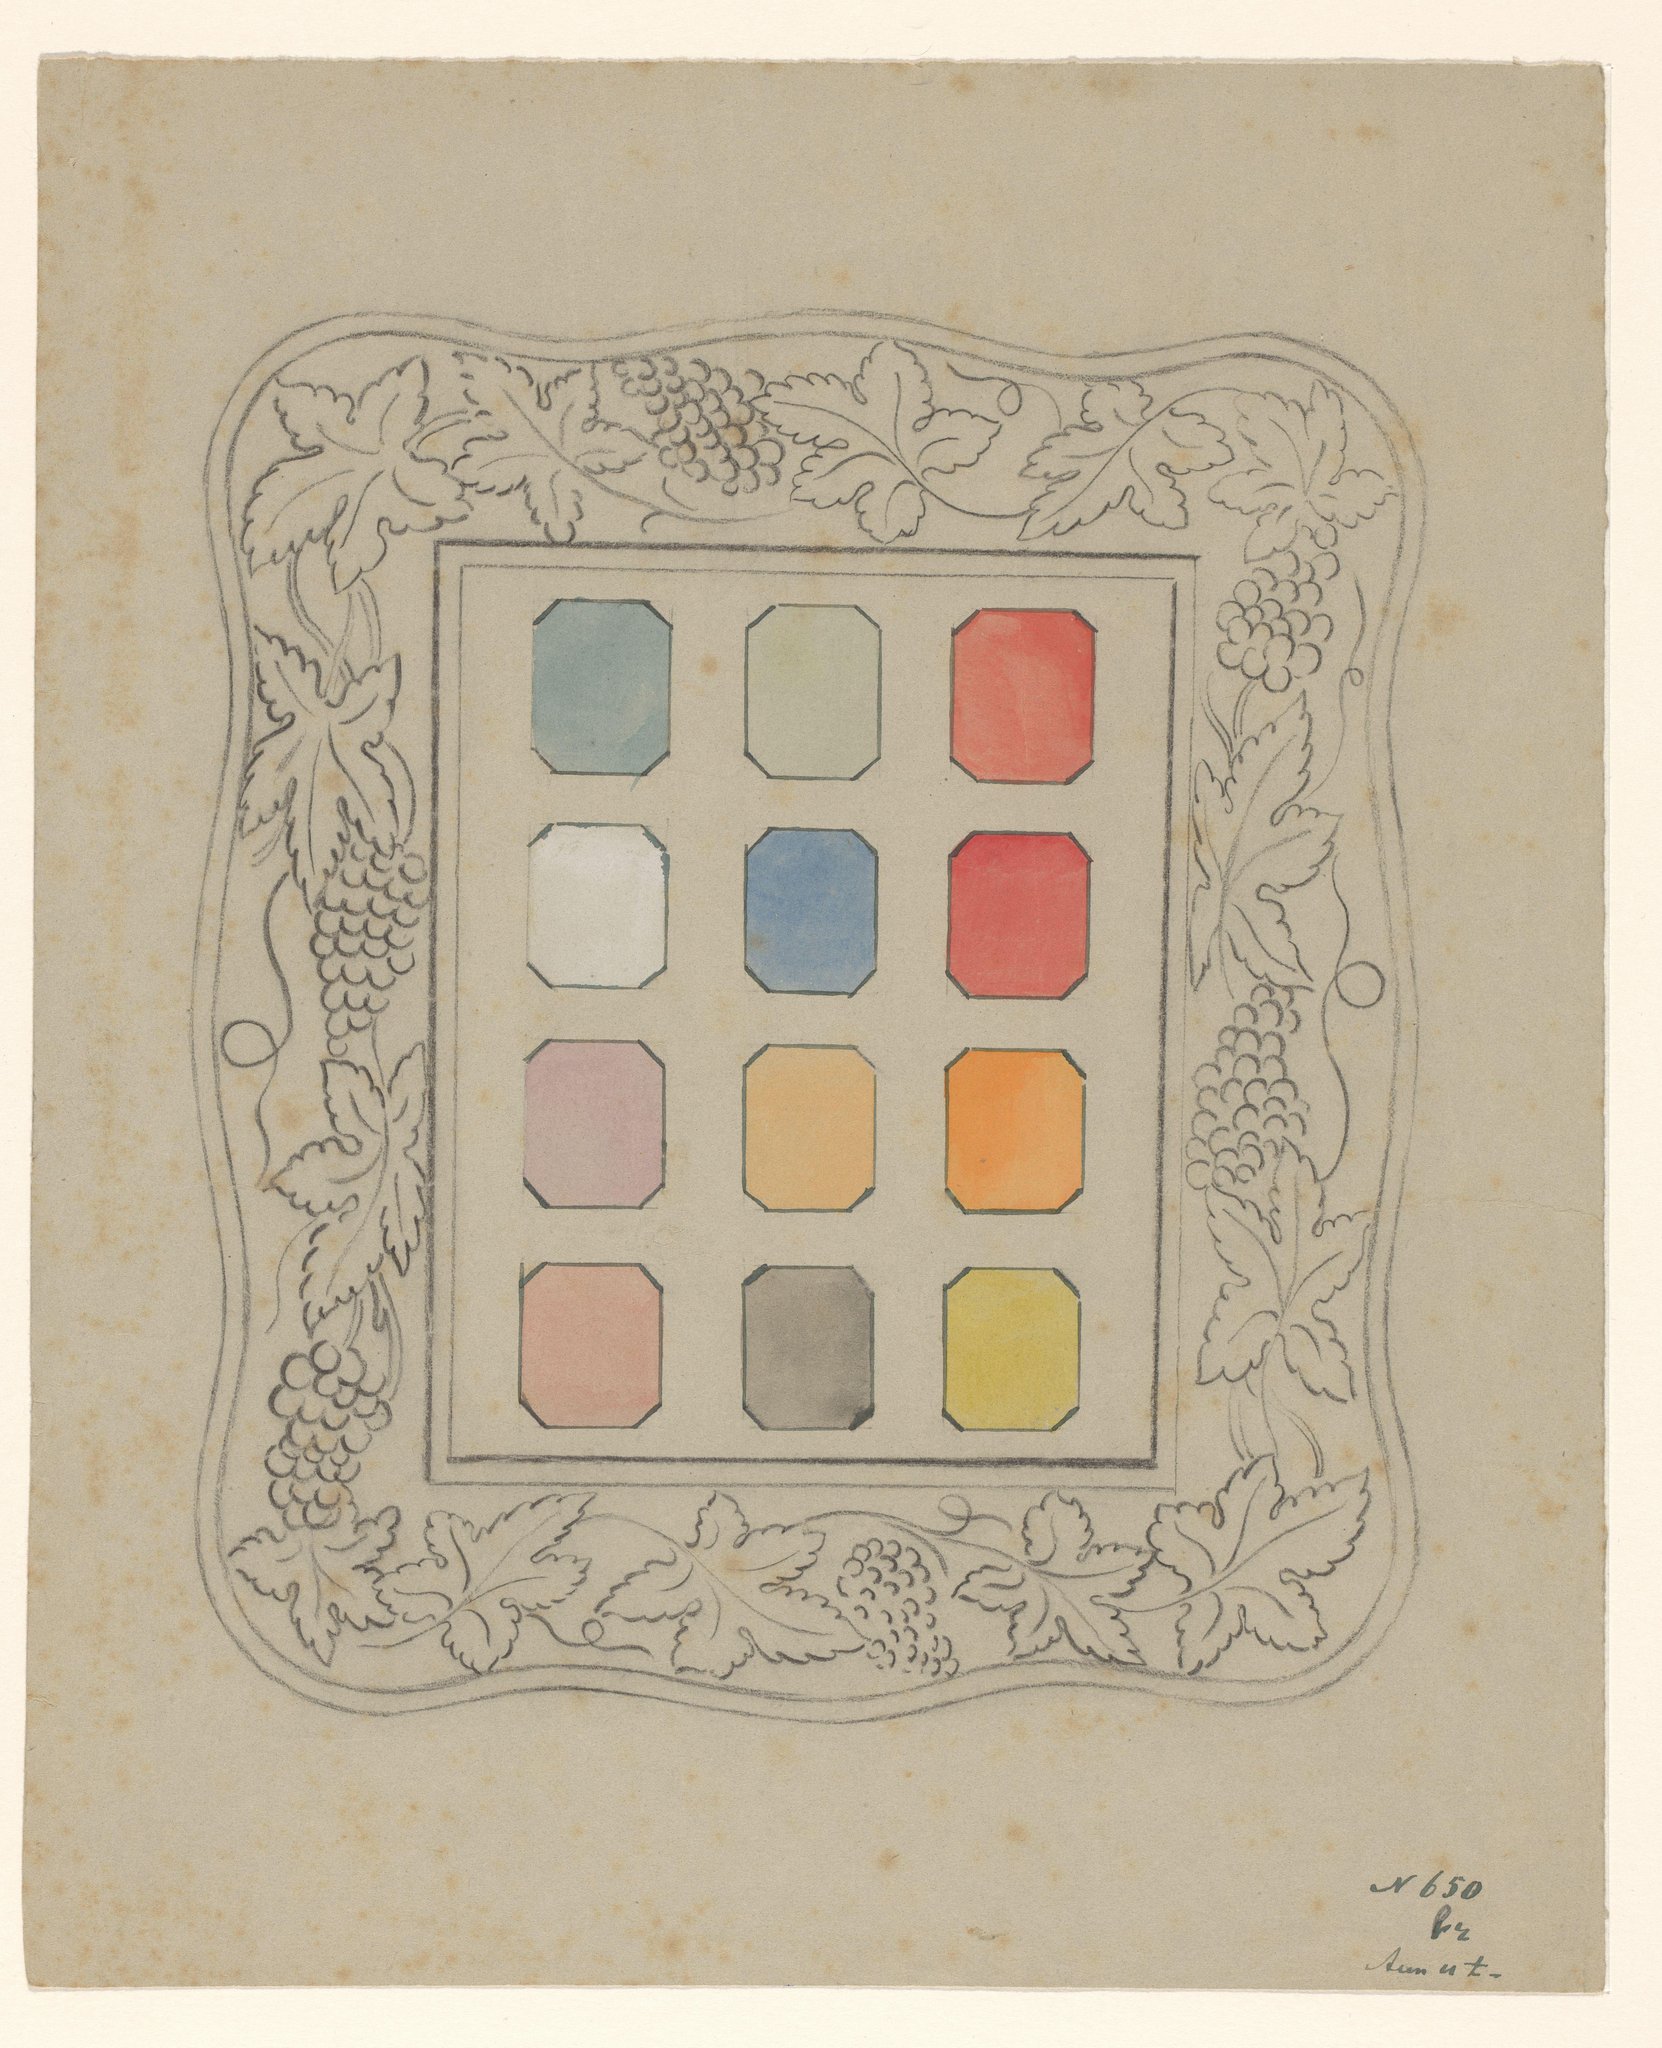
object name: design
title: Ontwerp voor een omlijsting met bladeren en druiven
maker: j.h. hellweg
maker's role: draughtsman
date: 1800-1899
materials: chalk, ink, paper, watercolor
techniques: brush, pen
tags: ornaments, jewels, foliage, tendrils, branches ~ ornament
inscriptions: annotation: ‘N650/ b[...]/ Aan u t.’, number: ‘65’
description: In de omlijsting twaalf vakken met verschillende kleuren.